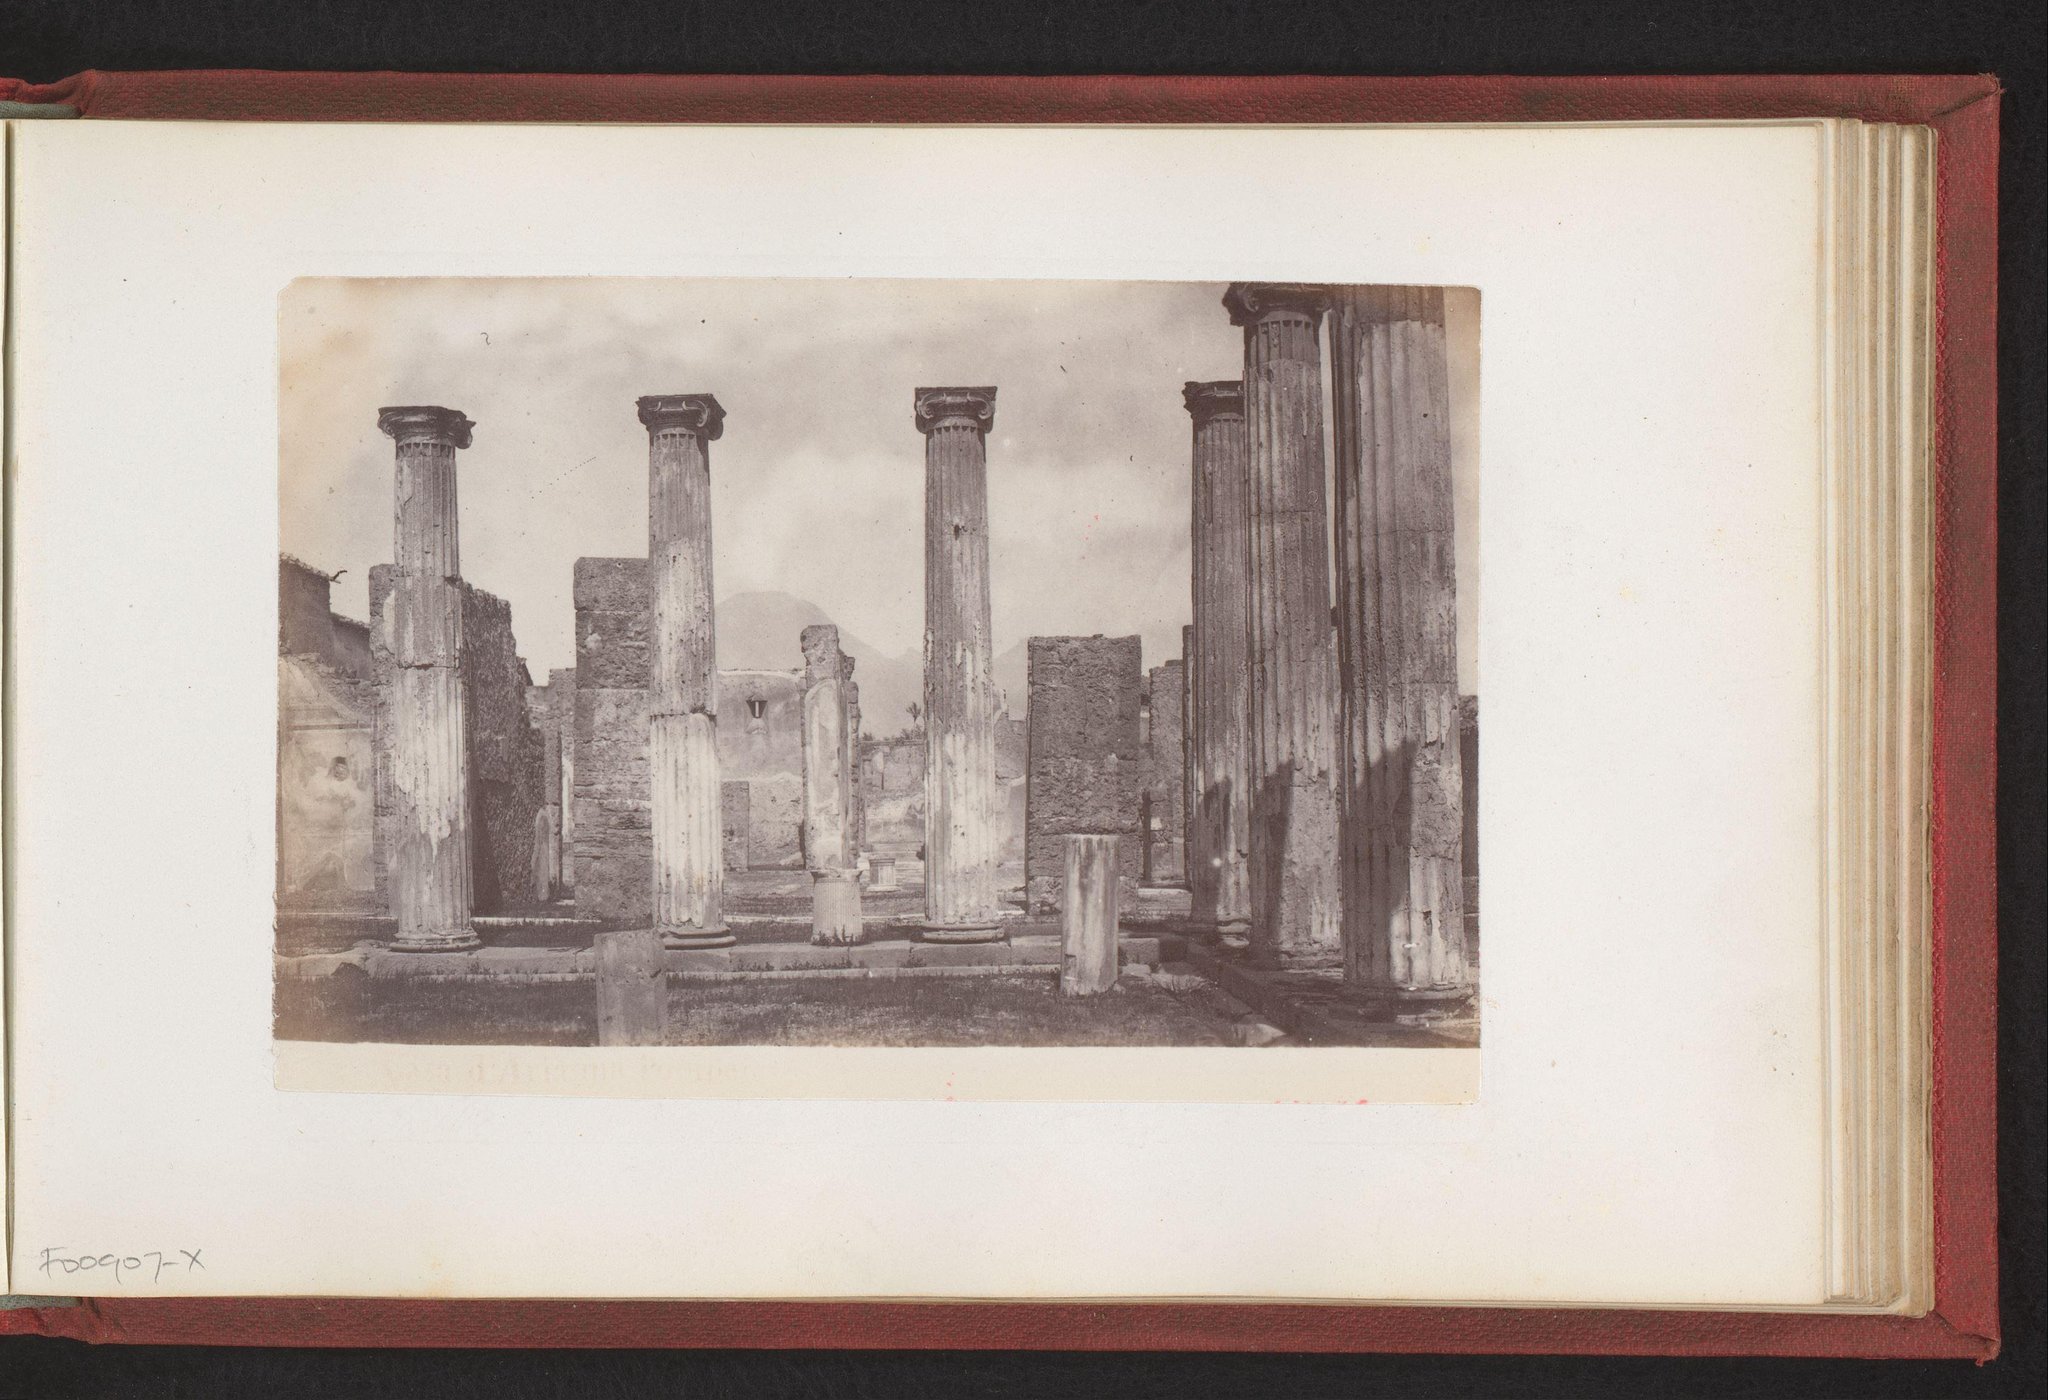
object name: photograph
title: Ruïne van Casa d'Ariana te Pompeï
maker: Anonymous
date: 1860-1900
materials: photographic support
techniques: albumen print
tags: column, pillar ~ architecture, ruin of a building ~ architecture, pompeii